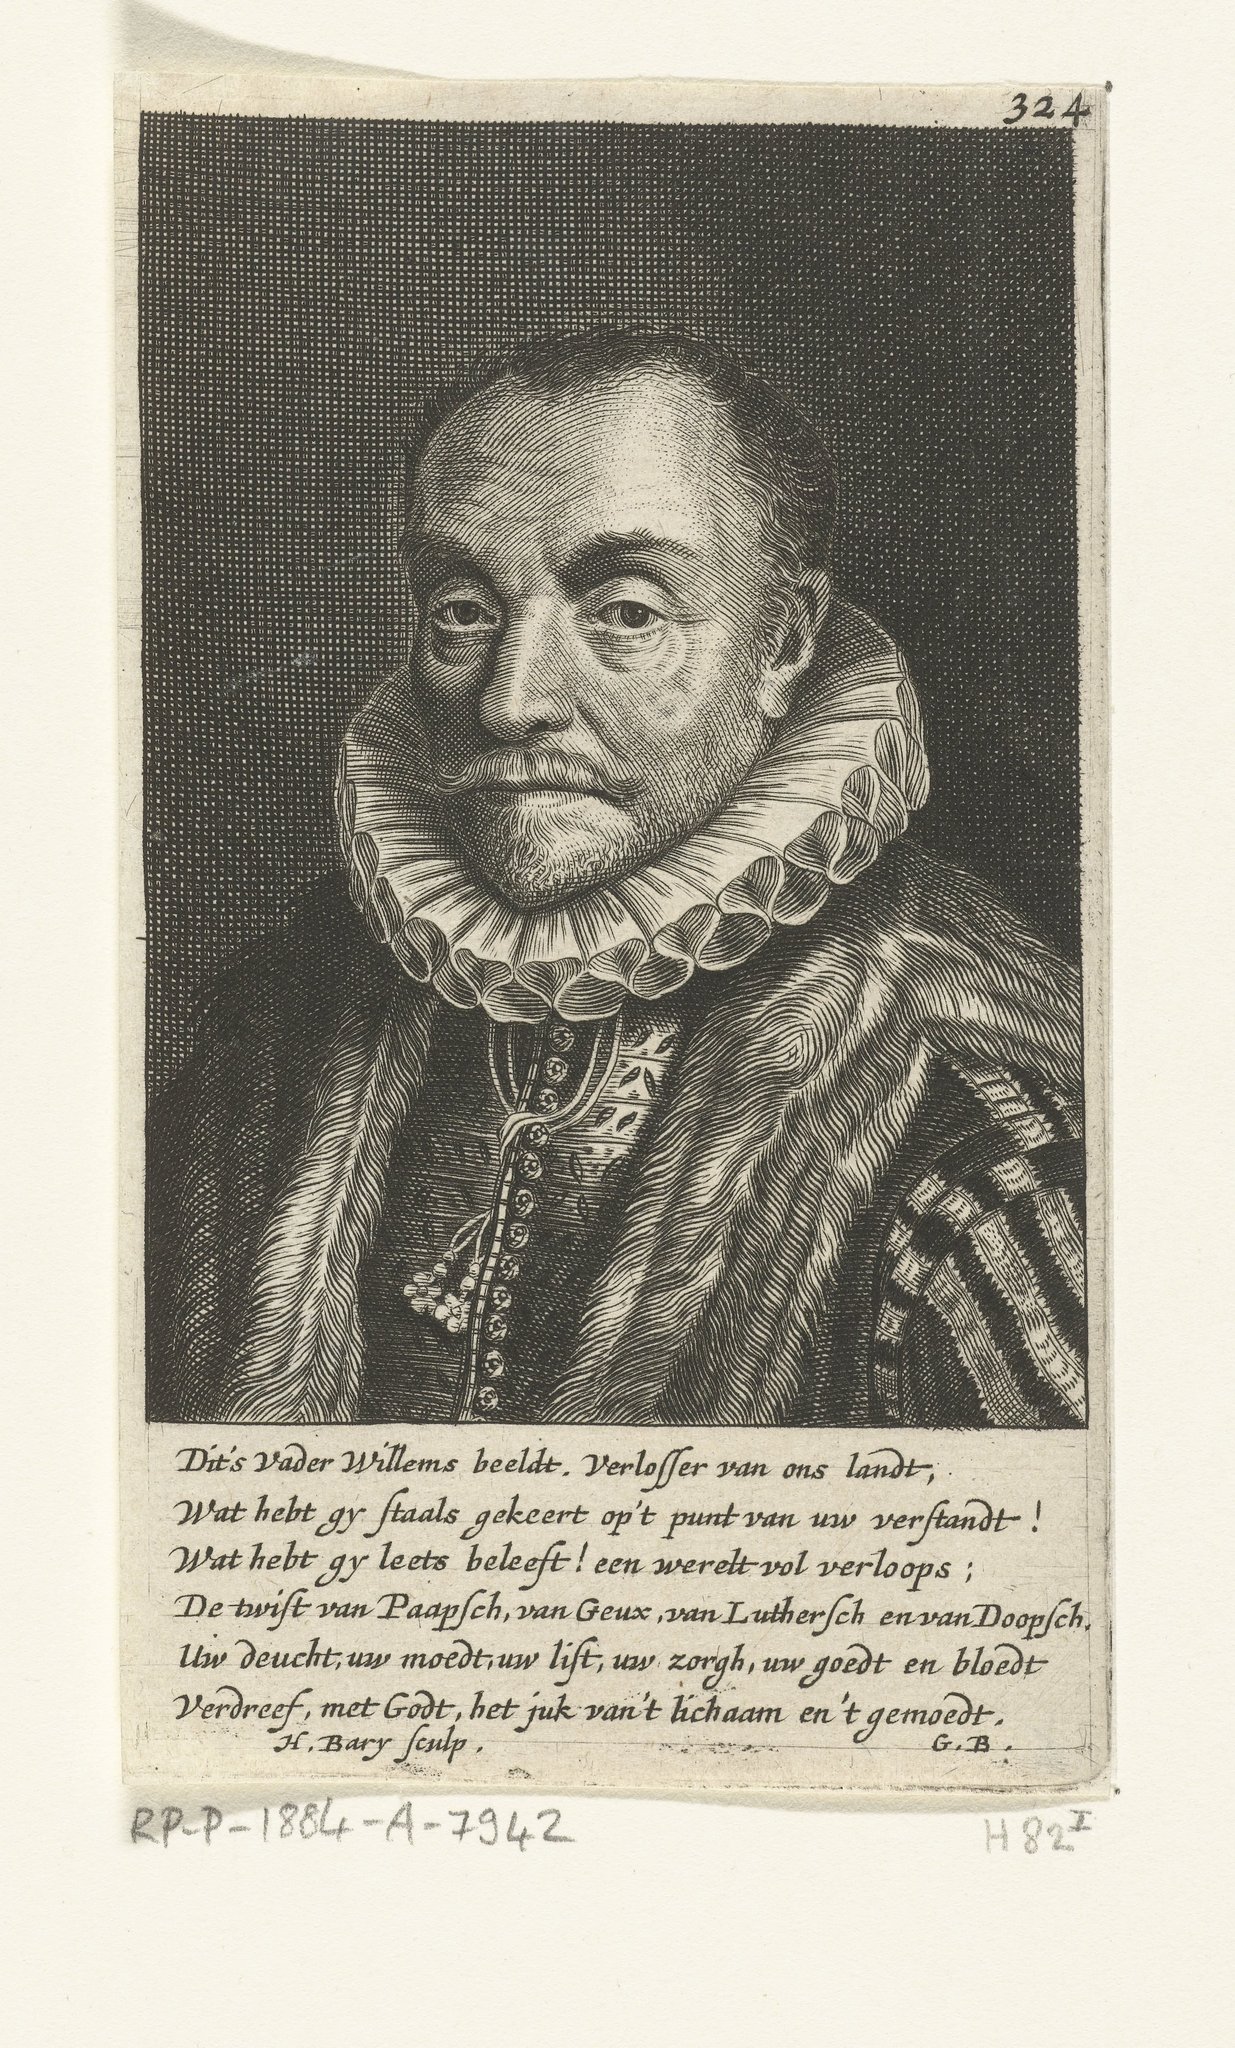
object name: print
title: Portret van Willem I, prins van Oranje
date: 1657-1707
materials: paper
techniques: engraving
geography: netherlands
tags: william i (prince of orange)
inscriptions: collector's mark: Lugt 2228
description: boekillustratie voor: G. Brandt, Verhaal van de reformatie, in en ontrent de Nederlanden, Amsterdam, voor J. Rieuwertsz, 1663, p. 324